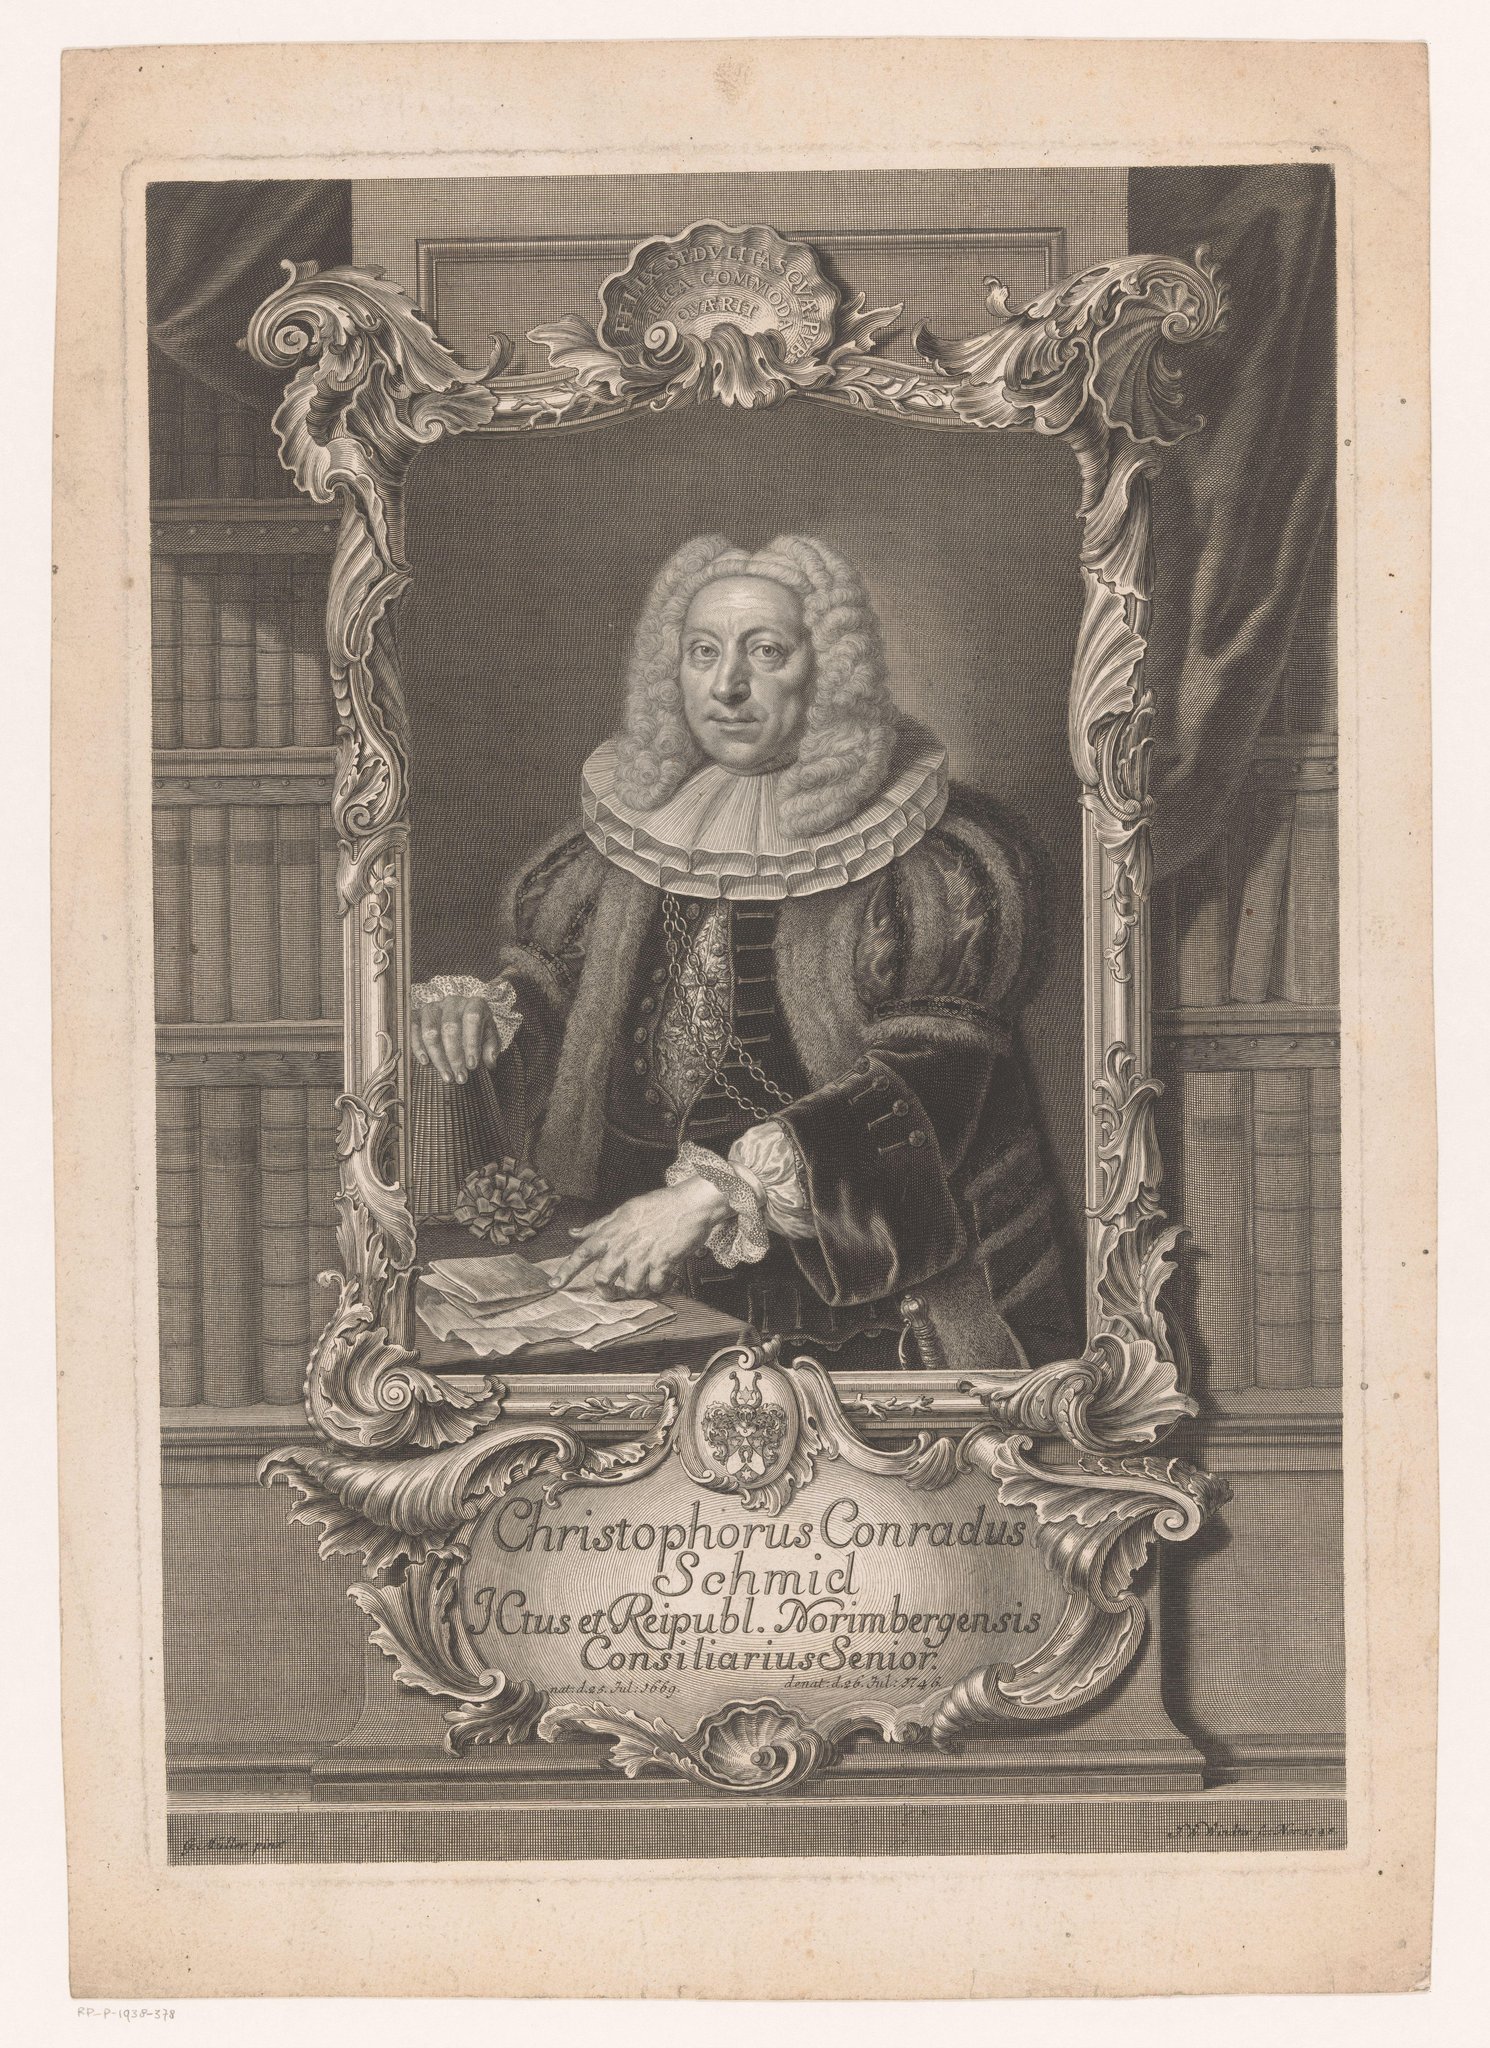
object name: print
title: Portret van Christoph Conrad Schmid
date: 1748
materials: paper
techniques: engraving, etching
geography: nuremberg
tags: historical persons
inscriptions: collector's mark: Lugt 2228